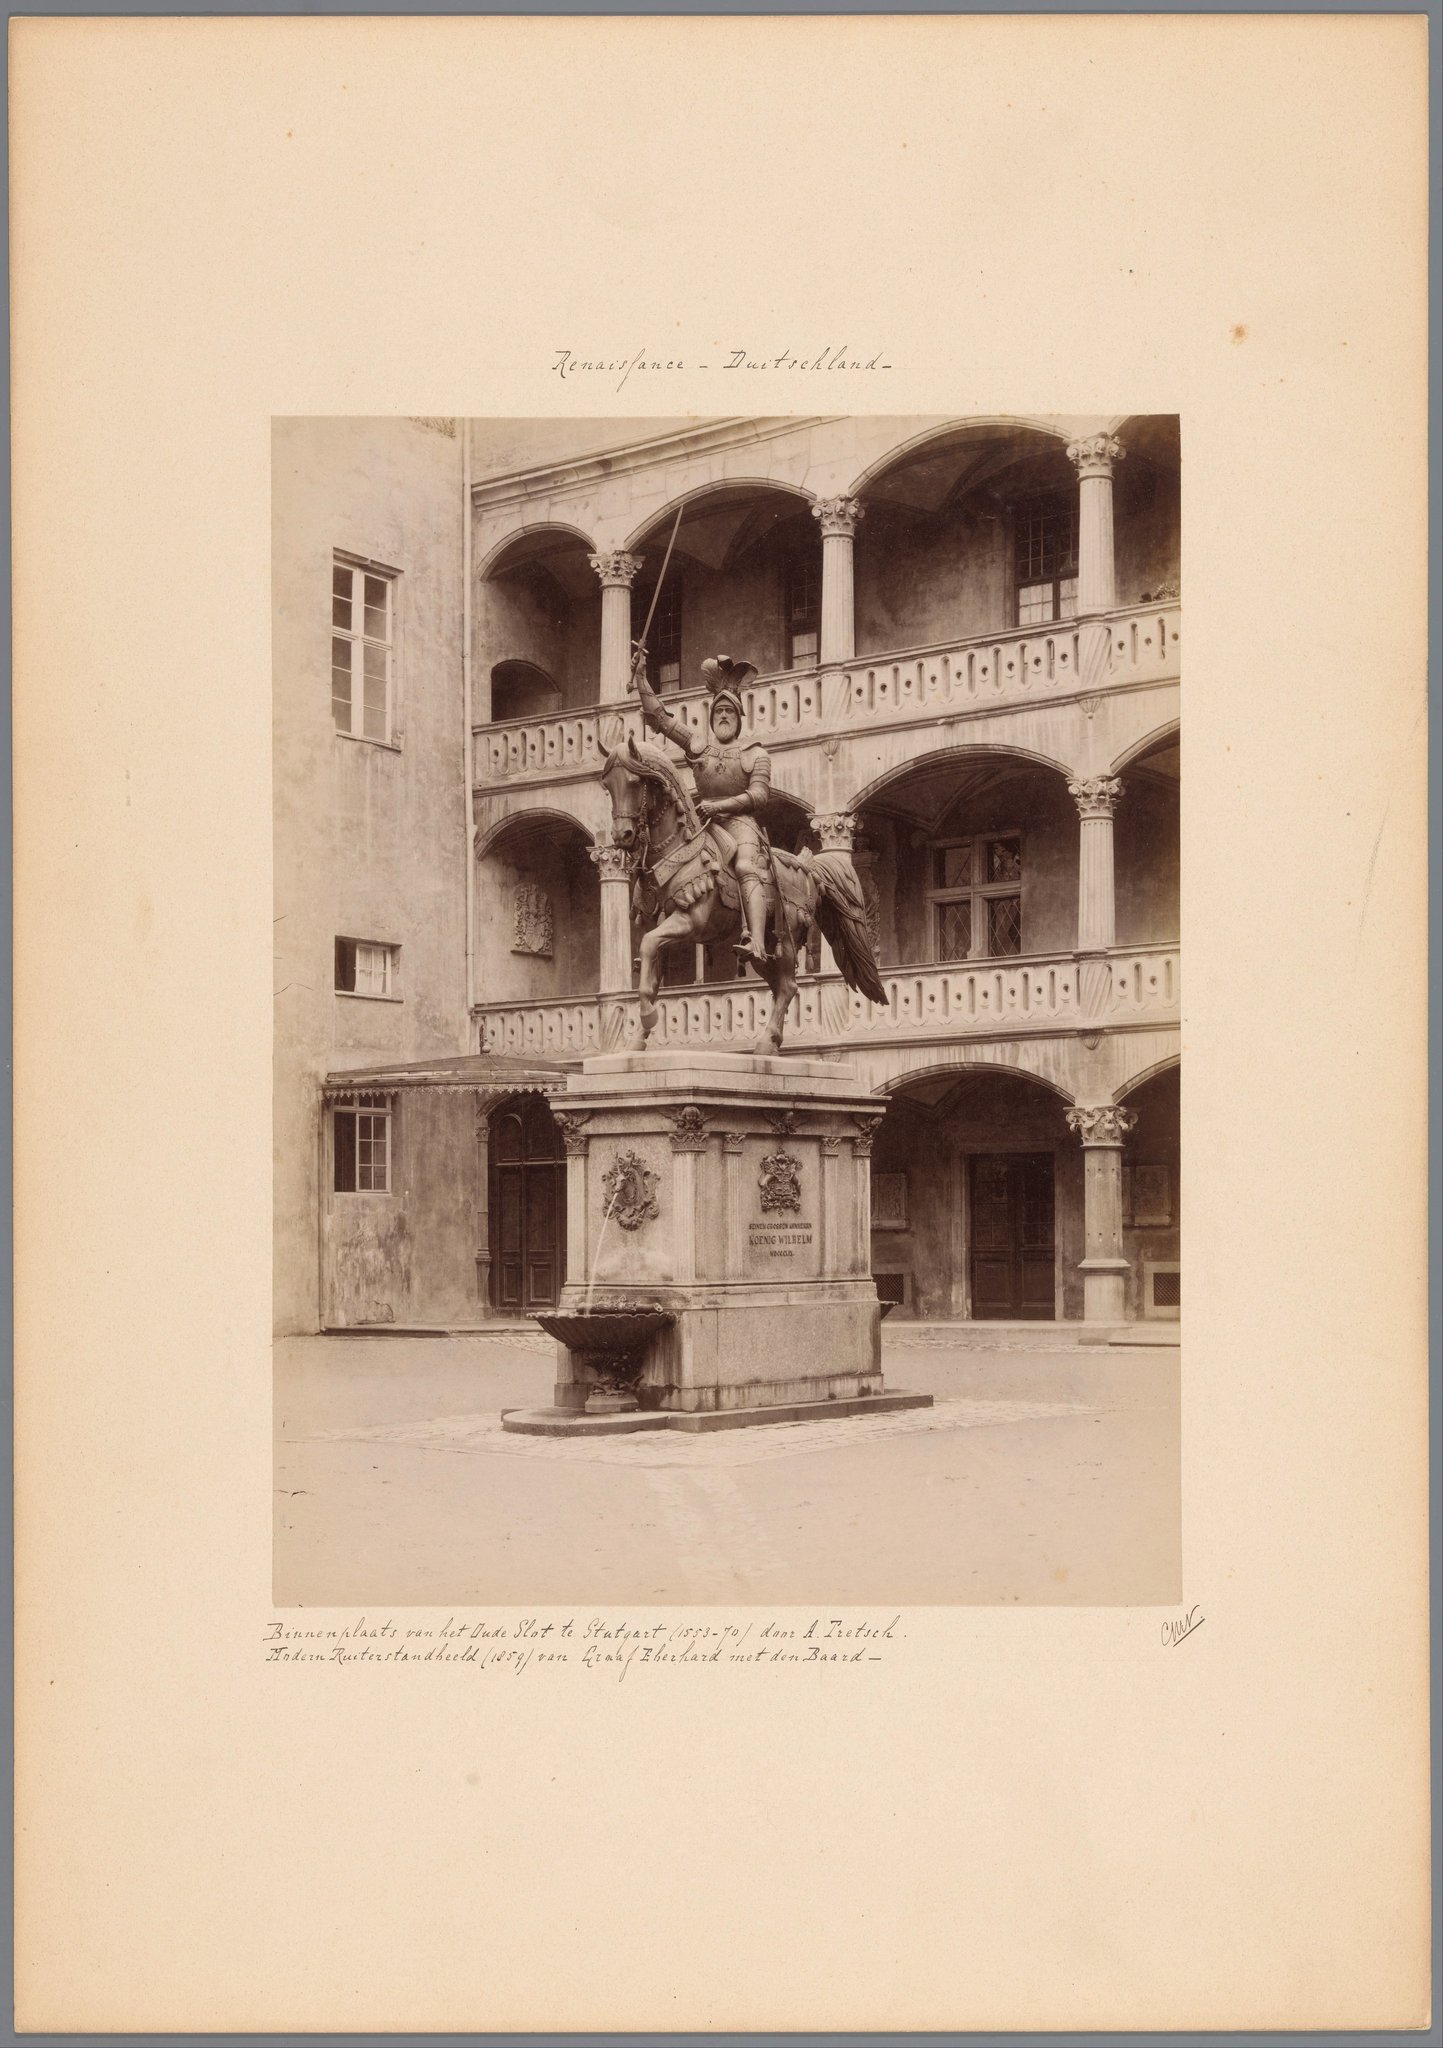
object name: photograph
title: Binnenplaats van het Oude Slot te Stutgart (1553-70) door A. Tretsch.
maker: hermann brandseph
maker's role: fotograaf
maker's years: 1826-1915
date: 1896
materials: cardboard, photographic support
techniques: albumen print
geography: stuttgart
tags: castle, equestrian statue, courtyard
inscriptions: inscription: ‘Renaissance - Duitschland.’, name: ‘H.BRANDSEPH Stuttgart 1896’, inscription: ‘CWN.’, collector's mark: ‘INSTITUUT VOOR KUNST-NIJVERHEIDSONDERWIJS GABRIËL METSUSTRAAT No. 16 AMSTERDAM’, collector's mark: ‘KUNSTNIJVERHEIDSCHOOL QUELLINUS AMSTERDAM FRANS HALSSTRAAT 14.’